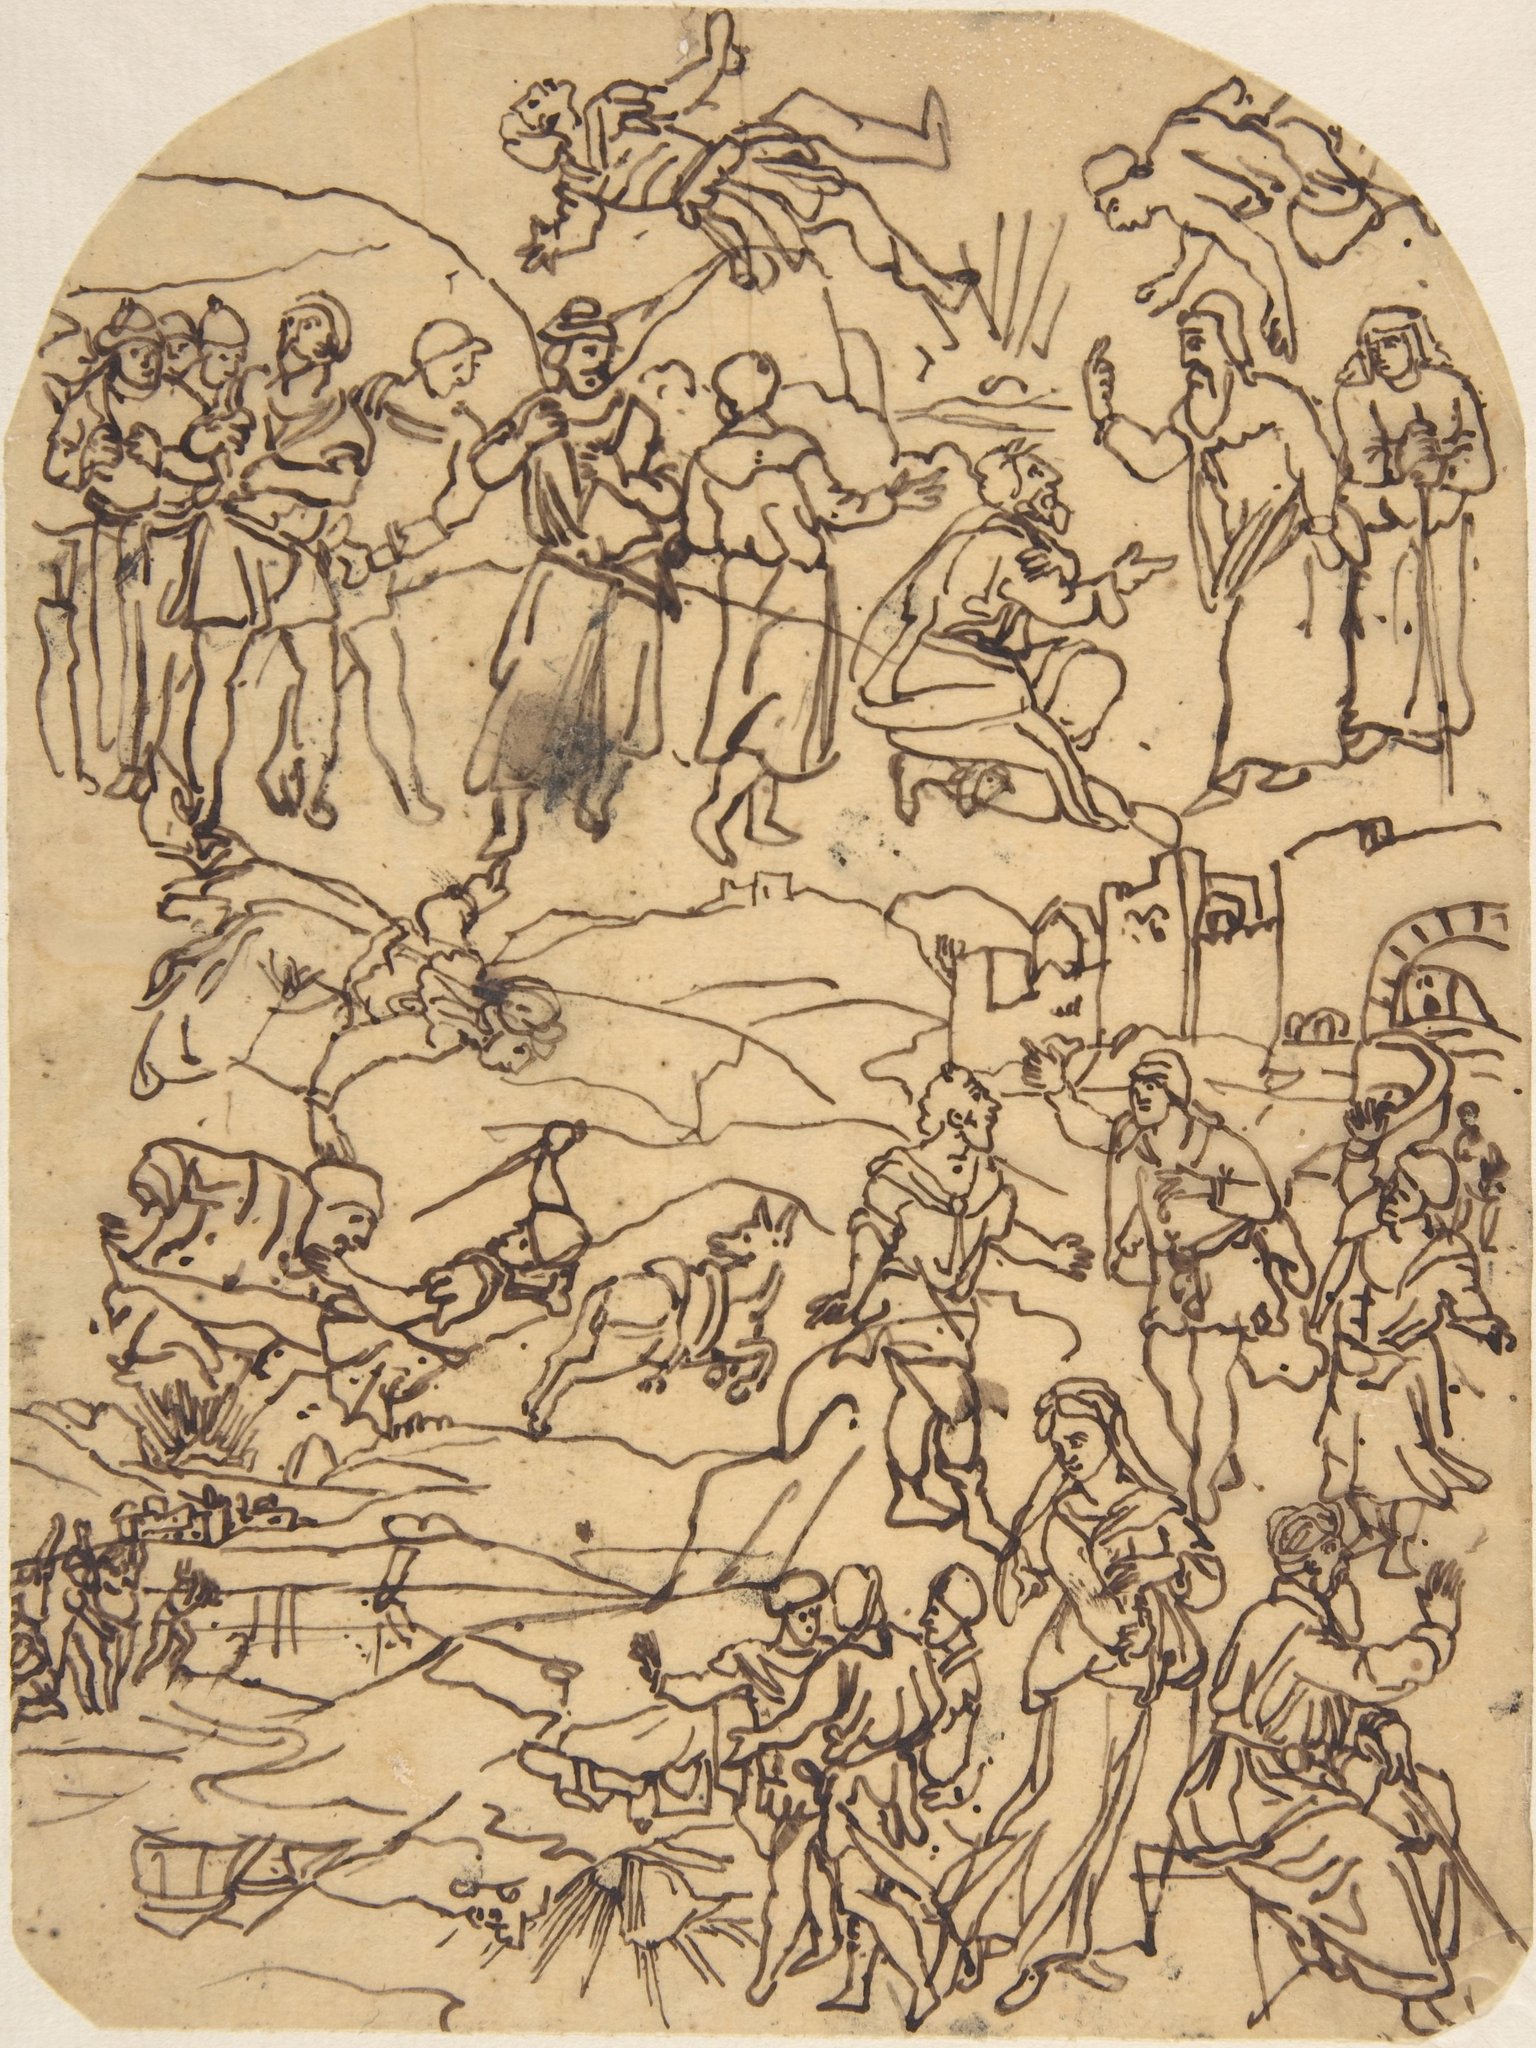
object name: drawing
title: Sketches of Classical or Biblical Figures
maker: rodolphe bresdin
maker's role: artist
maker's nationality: french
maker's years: 1822-1885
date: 1822-1885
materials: ink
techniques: pen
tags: men,women